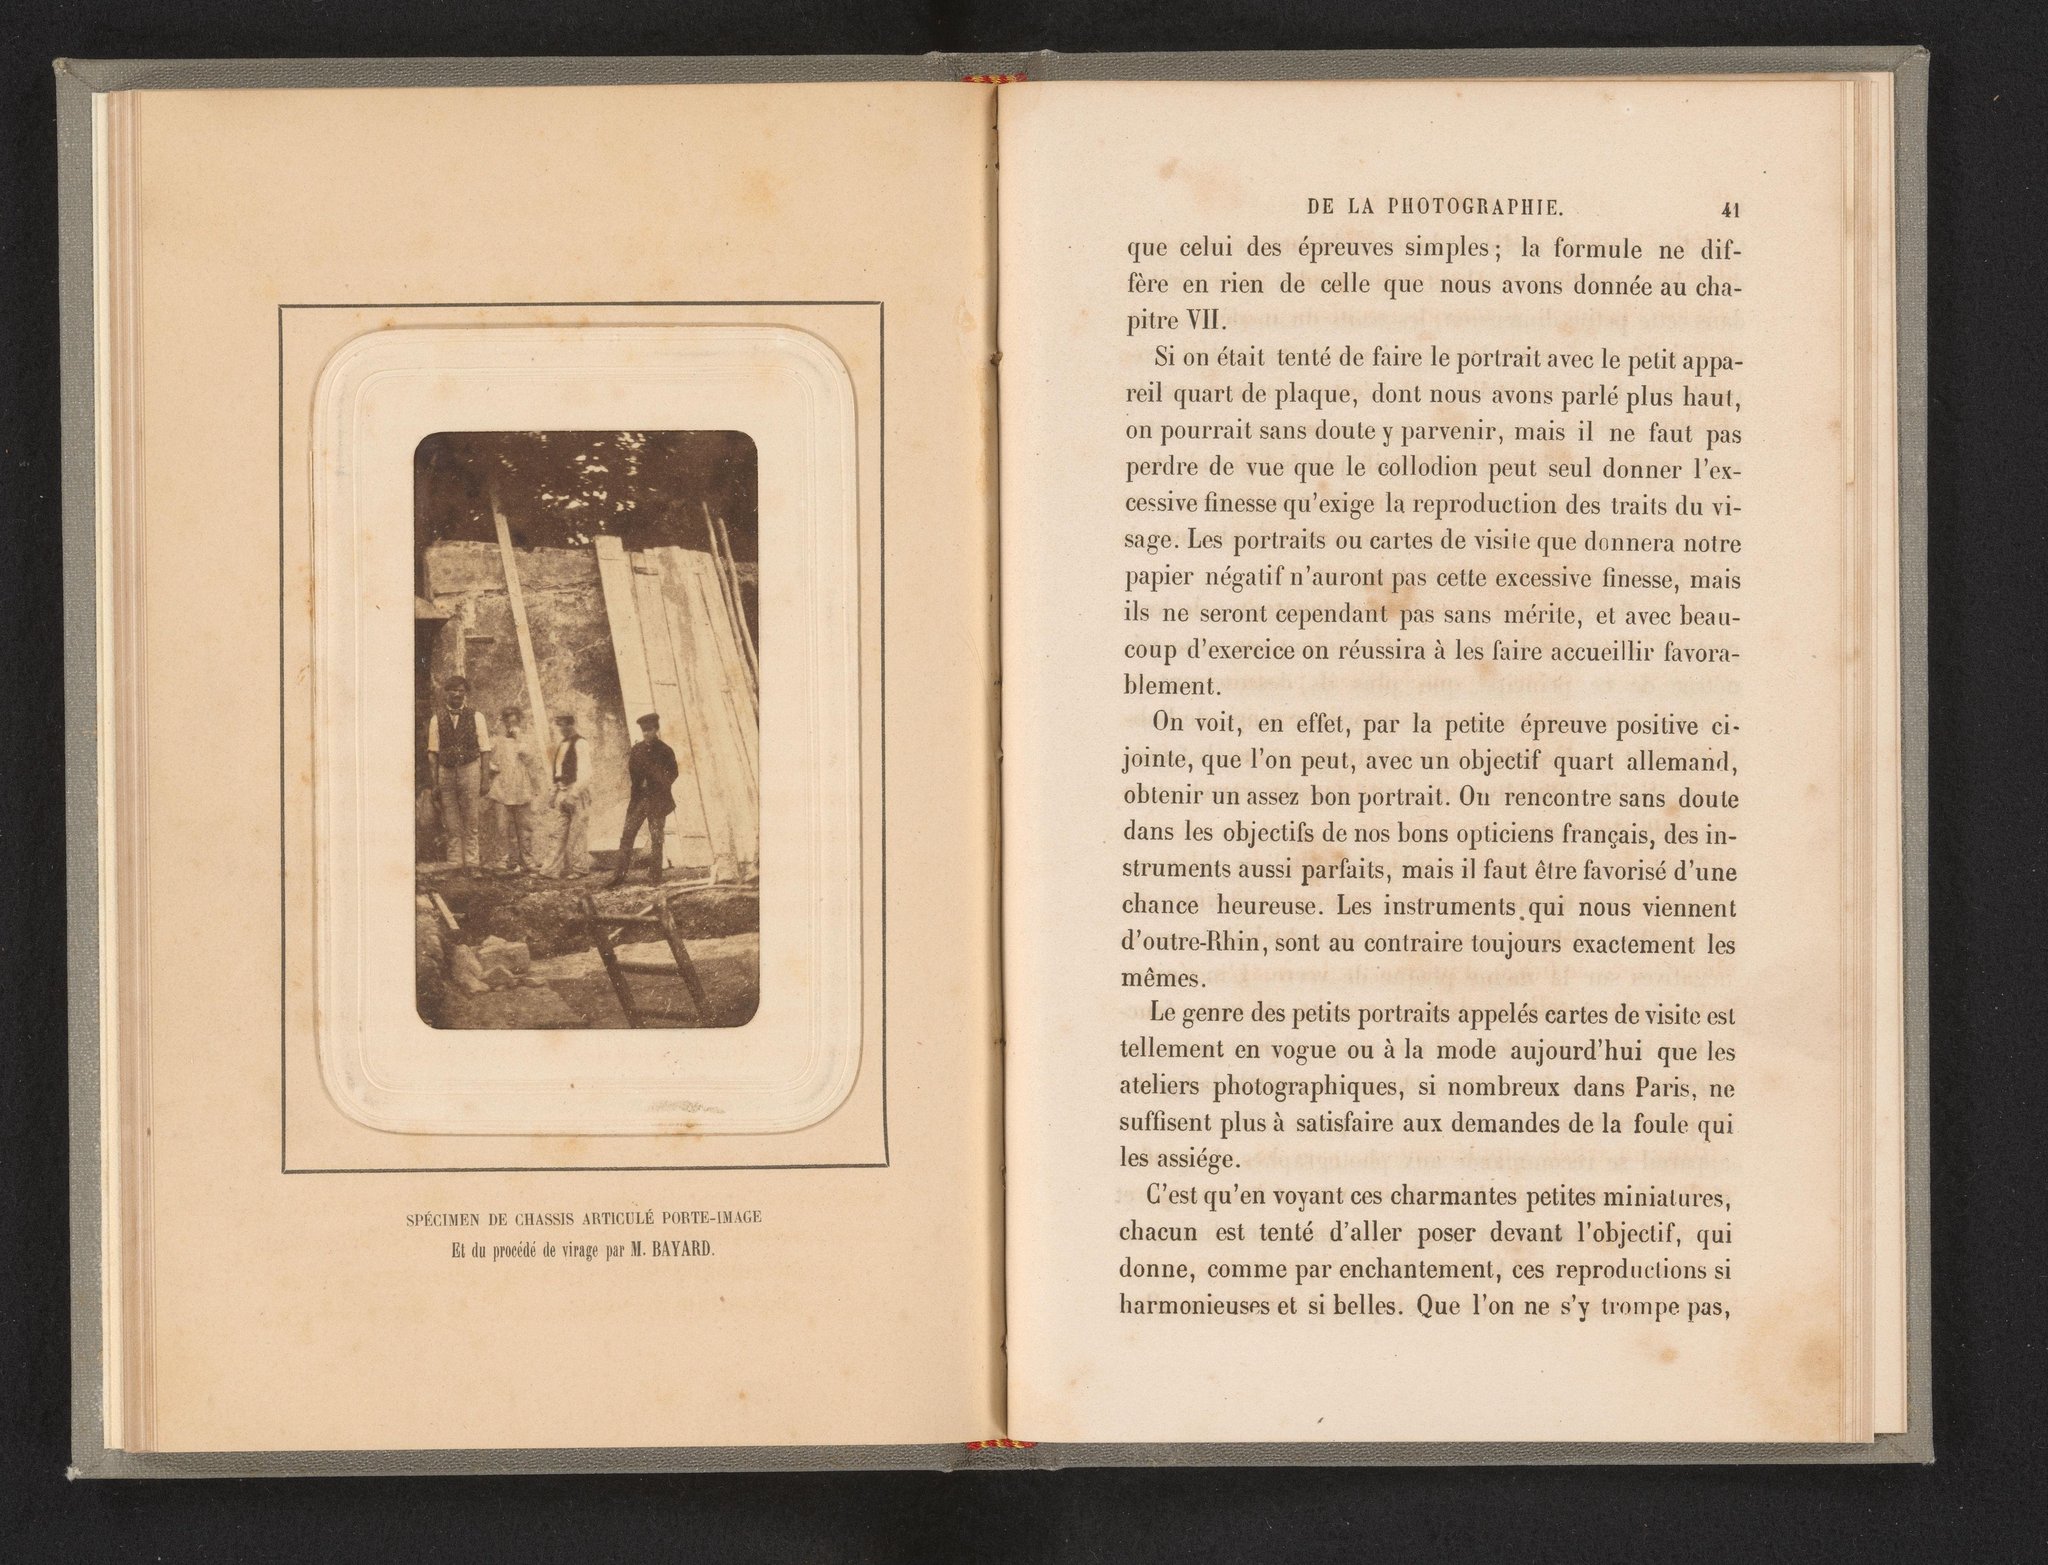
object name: page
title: Vier mannen op een bouwplaats of plankenzagerij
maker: Anonymous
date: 1855-1860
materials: cardboard, paper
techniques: albumen print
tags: industries ~ wood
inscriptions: inscription: ‘SPÉCIMEN DE CHASSIS ARTICULÉ PORTE-IMAGE/ Et du procédé de virage par M. BAYARD.’